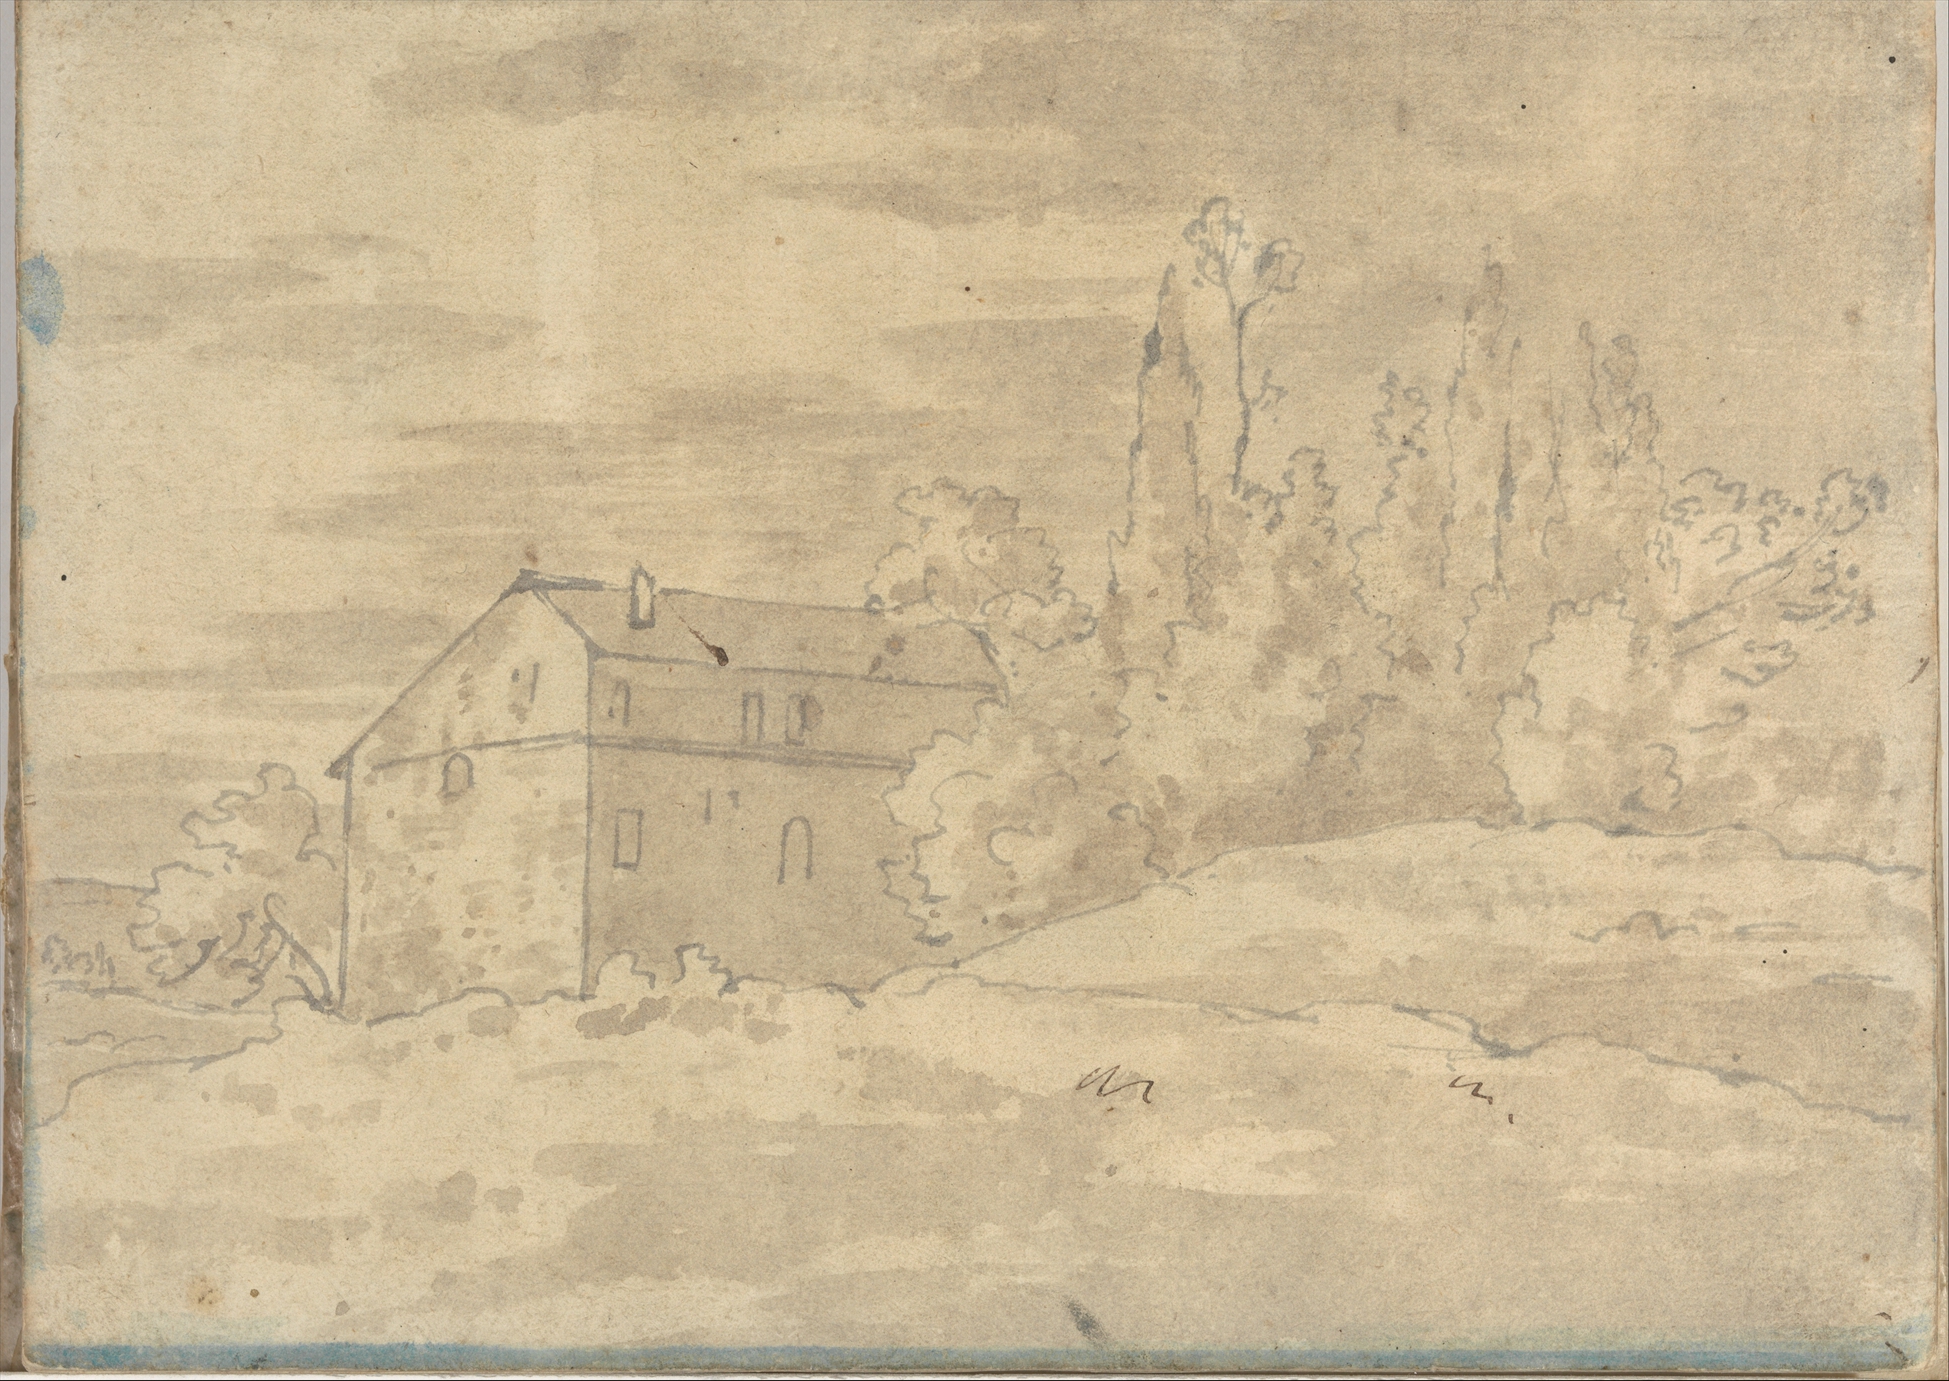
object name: drawing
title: A villa surrounded by trees, at Rome (Smaller Italian sketchbook, leaf 22 recto)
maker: joseph wright (wright of derby)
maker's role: artist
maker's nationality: british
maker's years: 1734-1797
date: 1774-1775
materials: graphite, ink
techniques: brush, pen, wash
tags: houses,landscapes